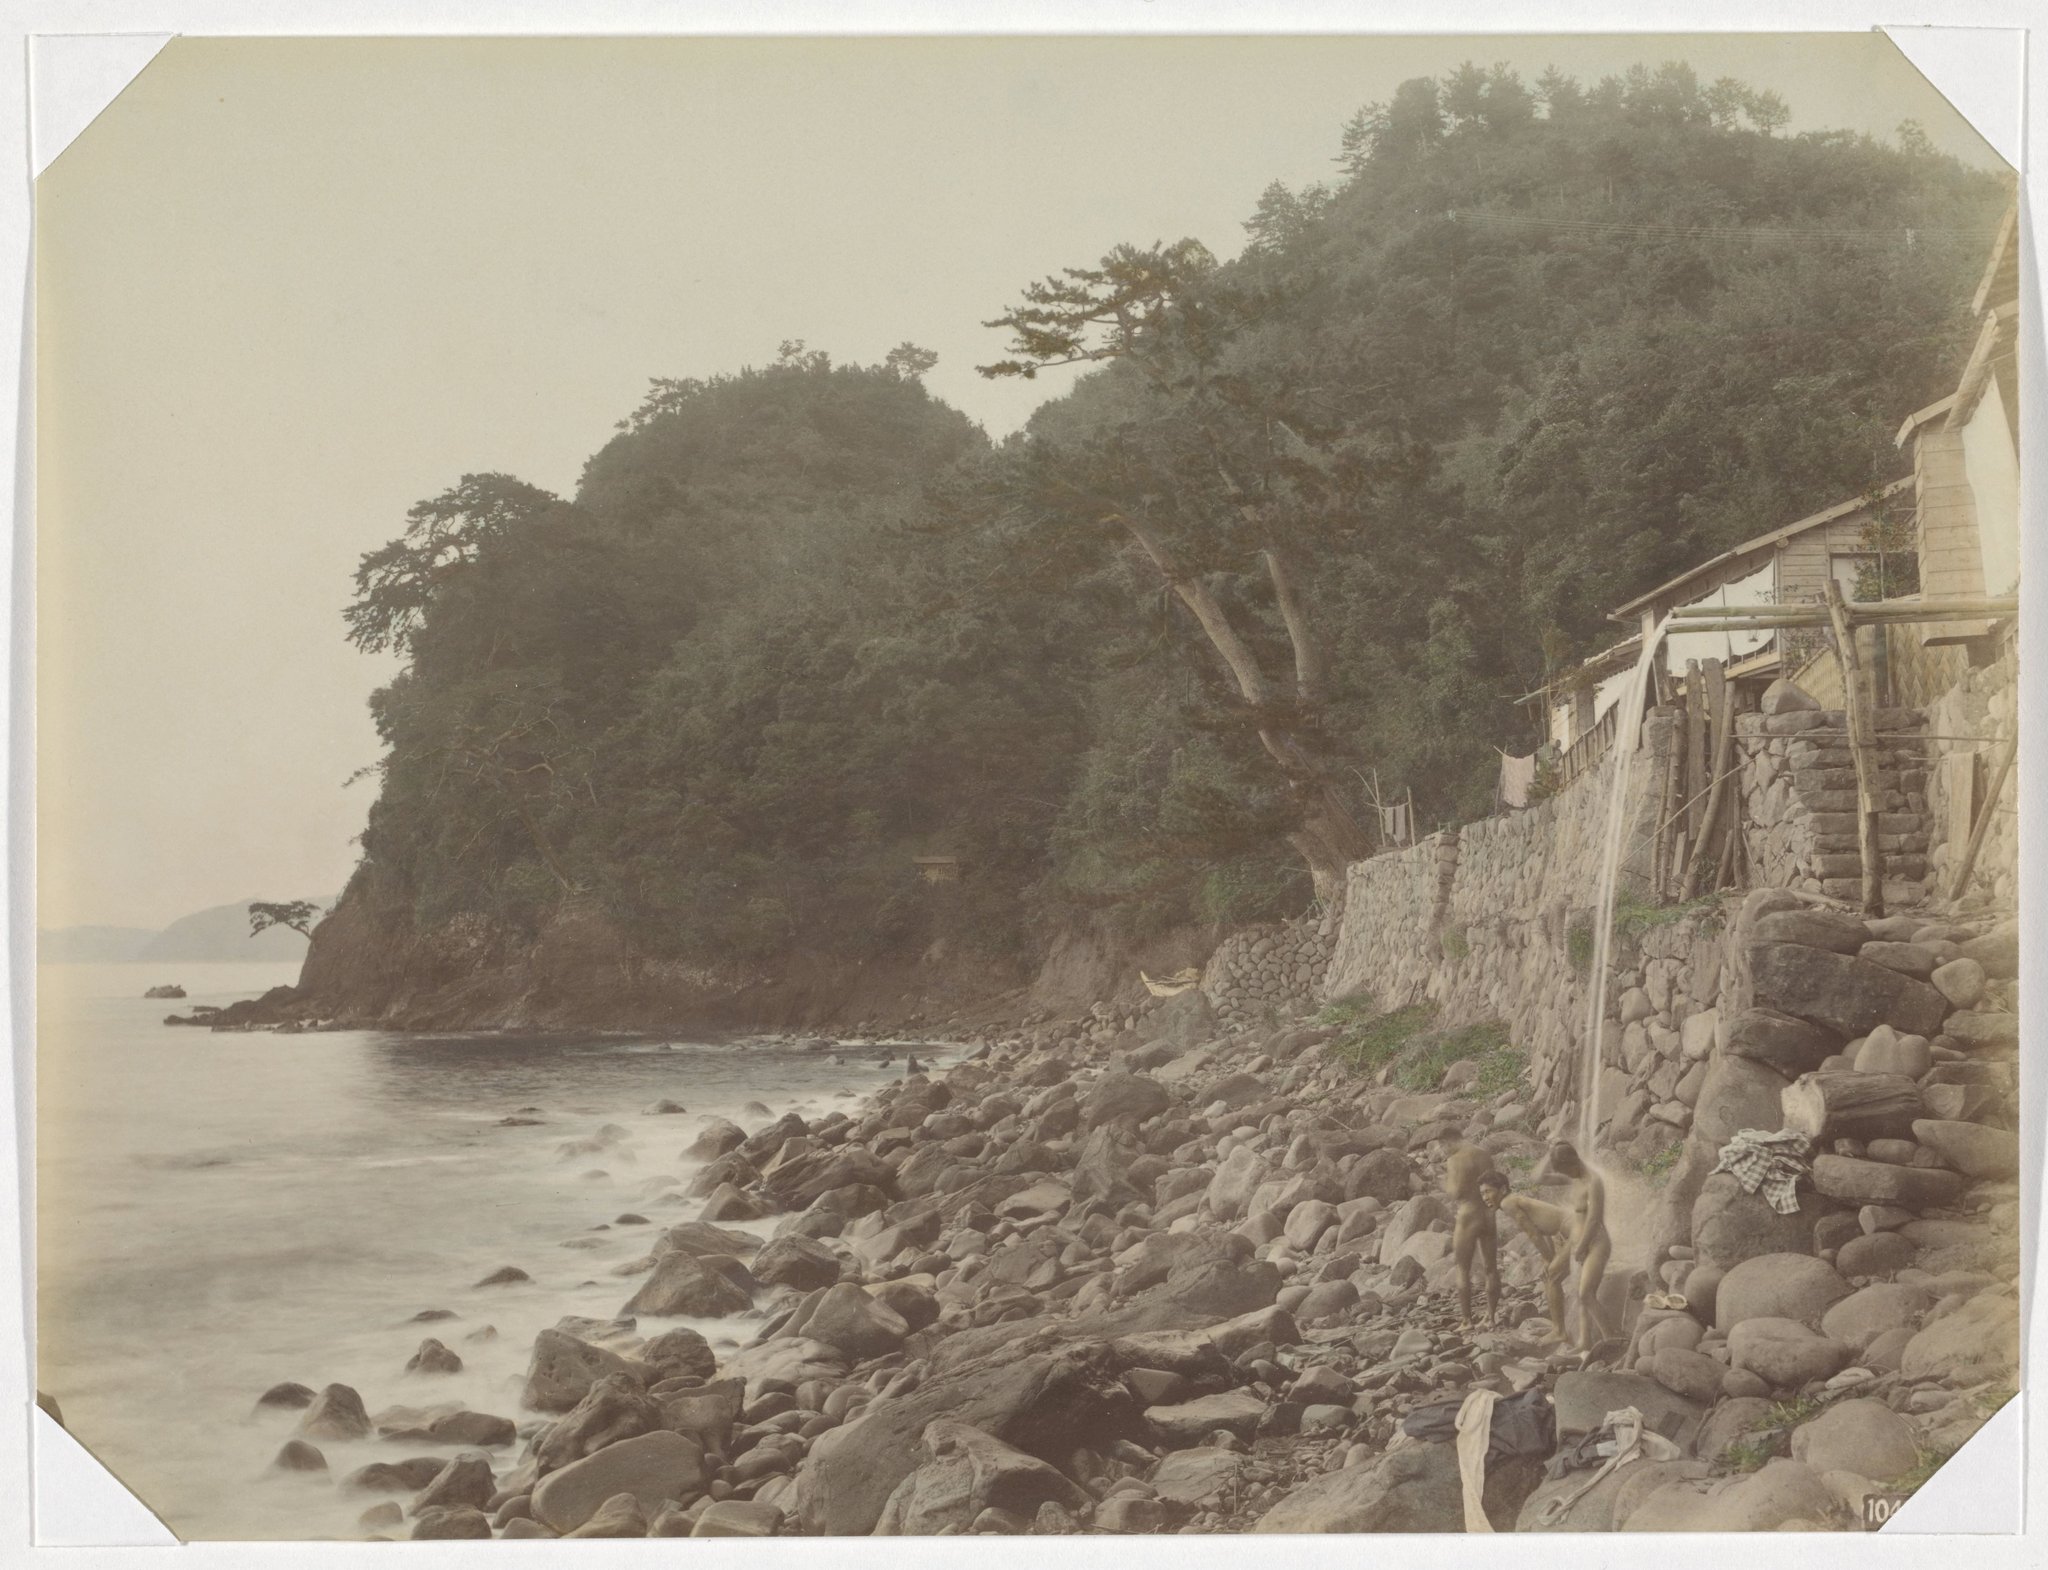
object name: photograph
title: Atami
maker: Anonymous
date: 1890-1894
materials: cardboard, paper, photographic support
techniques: albumen print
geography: atami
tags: coastal structures (+ landscape with figures, staffage)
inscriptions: negative number: ‘1041’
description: Onderdeel van Album met 69 foto's van een reis door Japan.